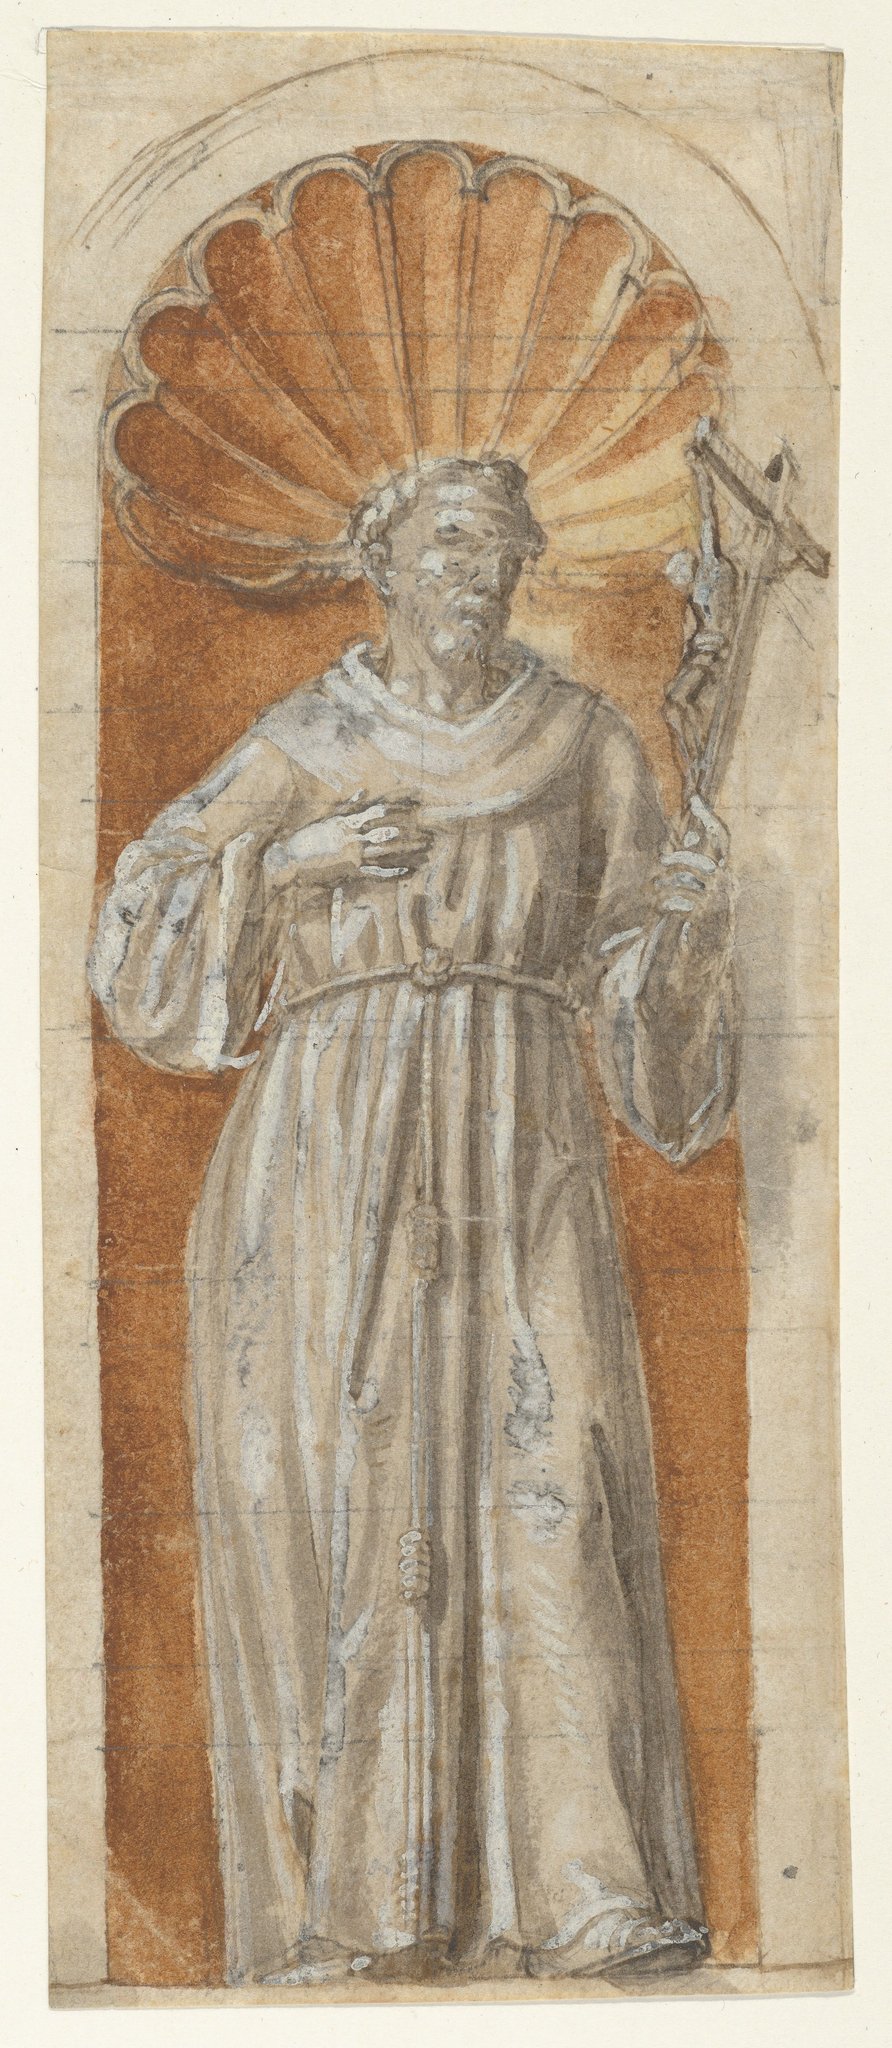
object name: drawing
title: Standing Franciscan Saint in a Niche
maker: anonymous, italian, roman-bolognese, 17th century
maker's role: artist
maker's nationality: italian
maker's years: 1600-1700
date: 1650-1700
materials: chalk, gouache, ink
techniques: brush, highlighting, pen, wash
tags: men,cross,crucifixion,saints